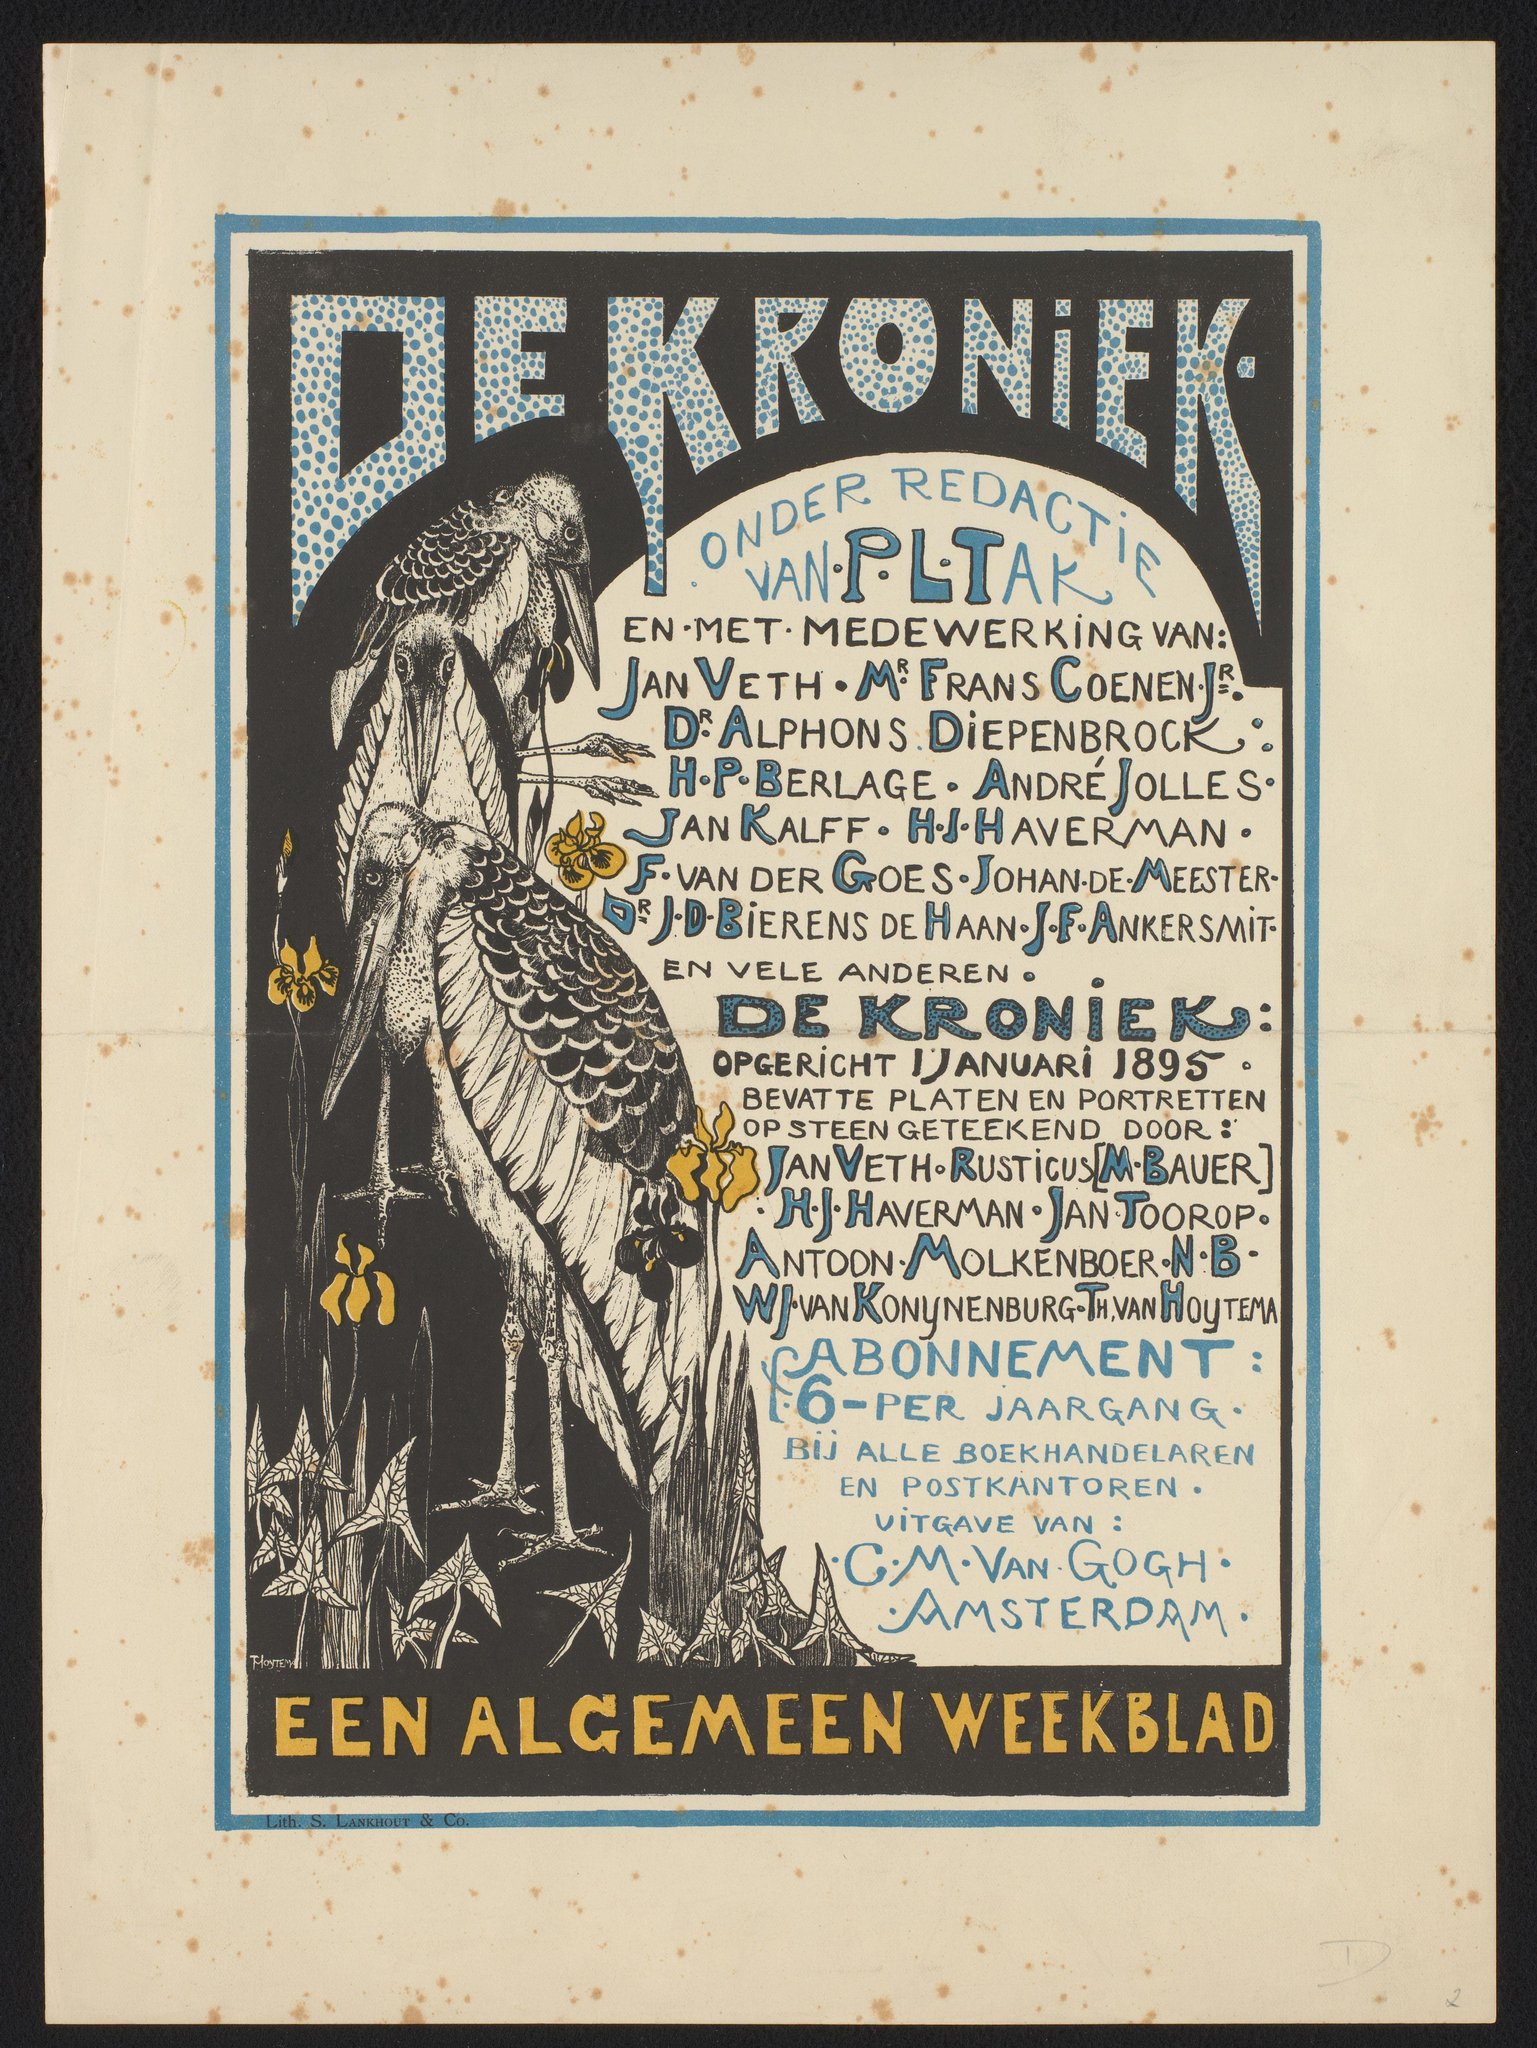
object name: poster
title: Affiche ter aankondiging van het tijdschrift 'De kroniek'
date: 1895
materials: paper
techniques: lithograph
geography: amsterdam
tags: birds, flowers: lily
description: Affiche ter promotie van: Tak, P.L. (red.). De kroniek, een algemeen weekblad. Amstserdam: C.M. van Gogh, 1895.